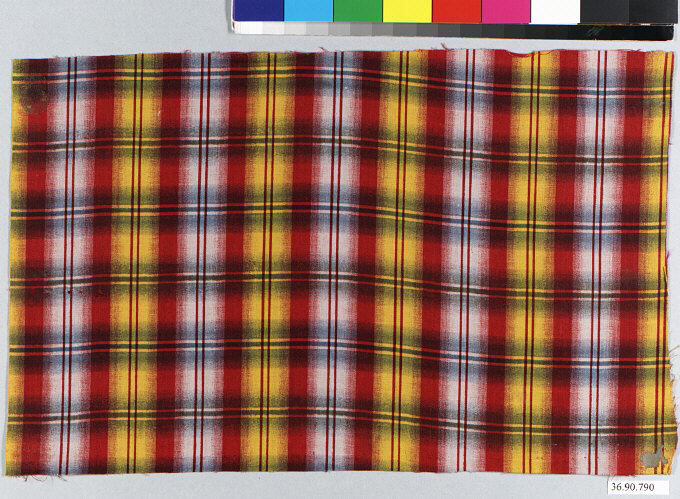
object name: piece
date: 1867-1900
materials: cotton